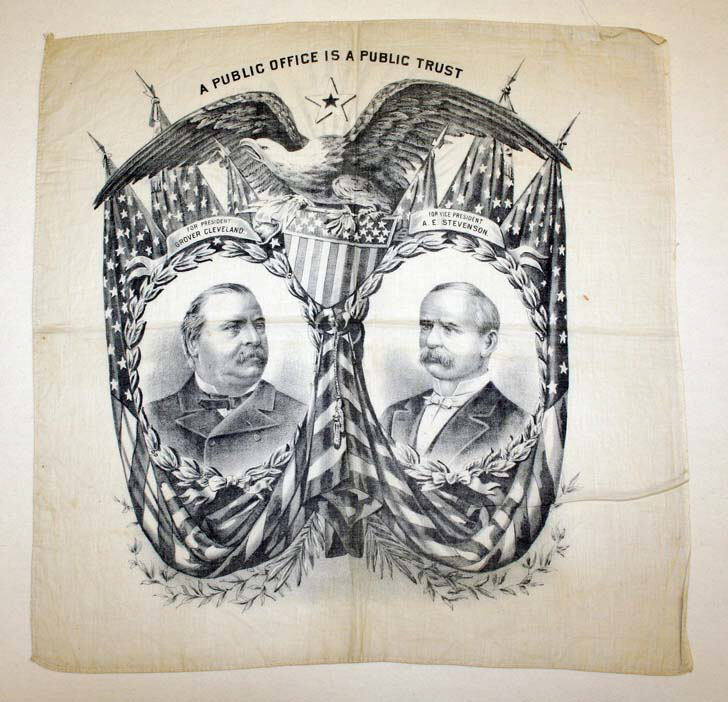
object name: handkerchief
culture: american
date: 1893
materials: cotton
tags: elections,men,portraits,politics